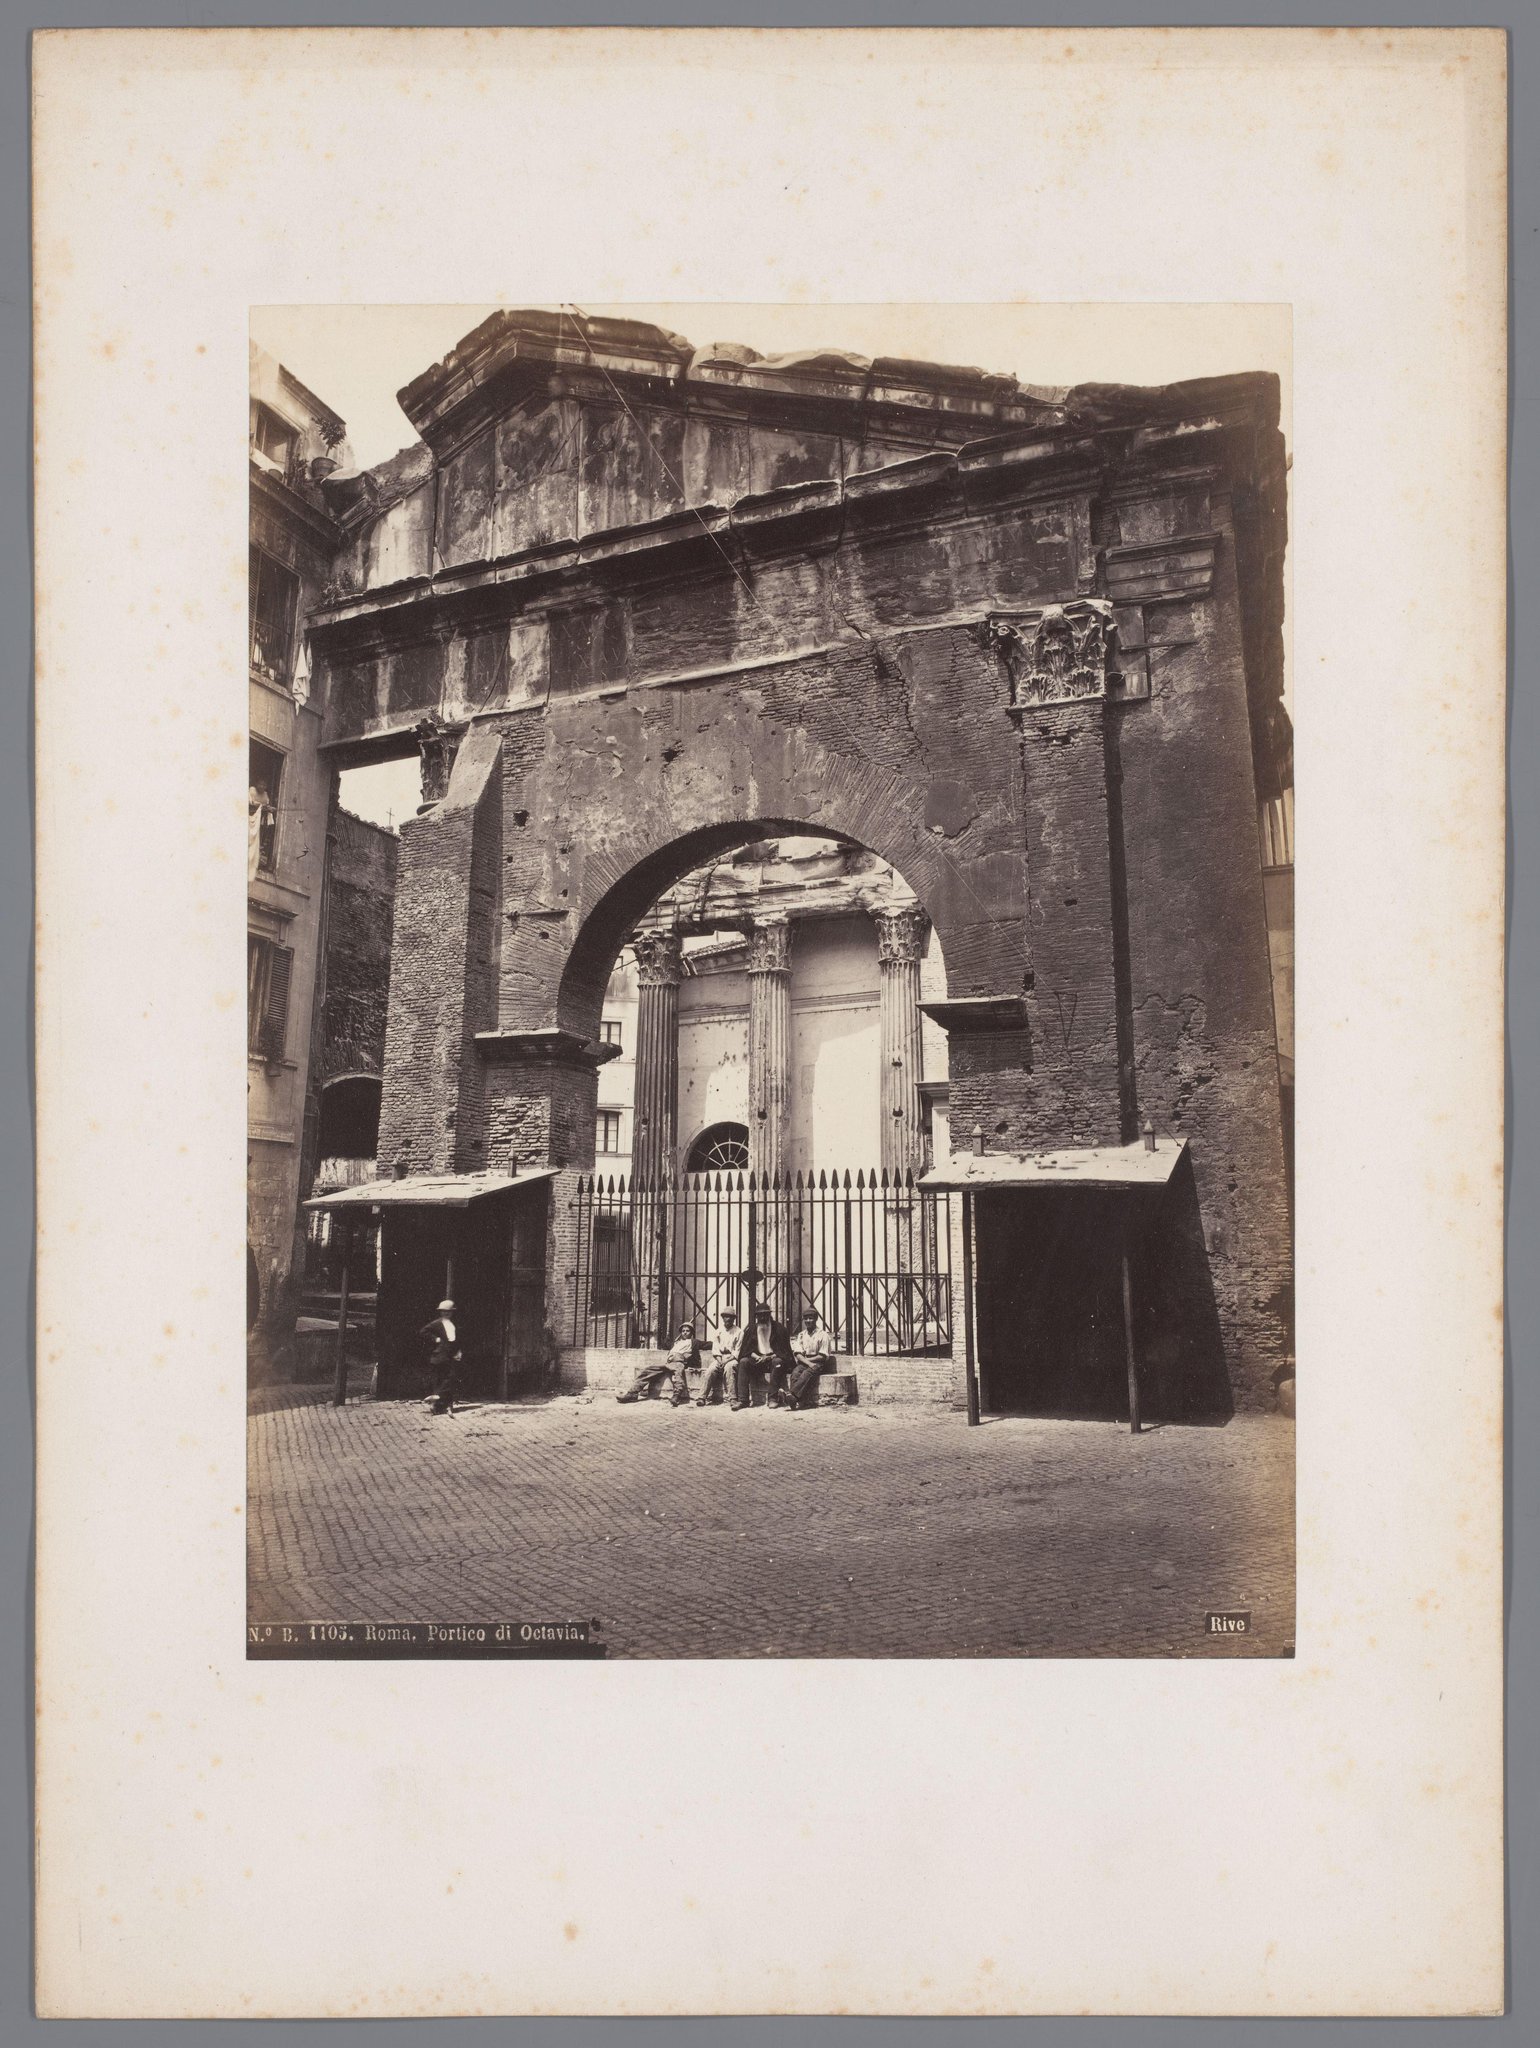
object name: photograph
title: Roma. Portico di Octavia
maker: roberto rive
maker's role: fotograaf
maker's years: 1825-1868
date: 1860-1889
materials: cardboard, paper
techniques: albumen print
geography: rome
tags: ruin of a building ~ architecture, arch, archivolt ~ architecture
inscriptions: number: ‘No. B. 1105.’, number: ‘43’, number: ‘8’